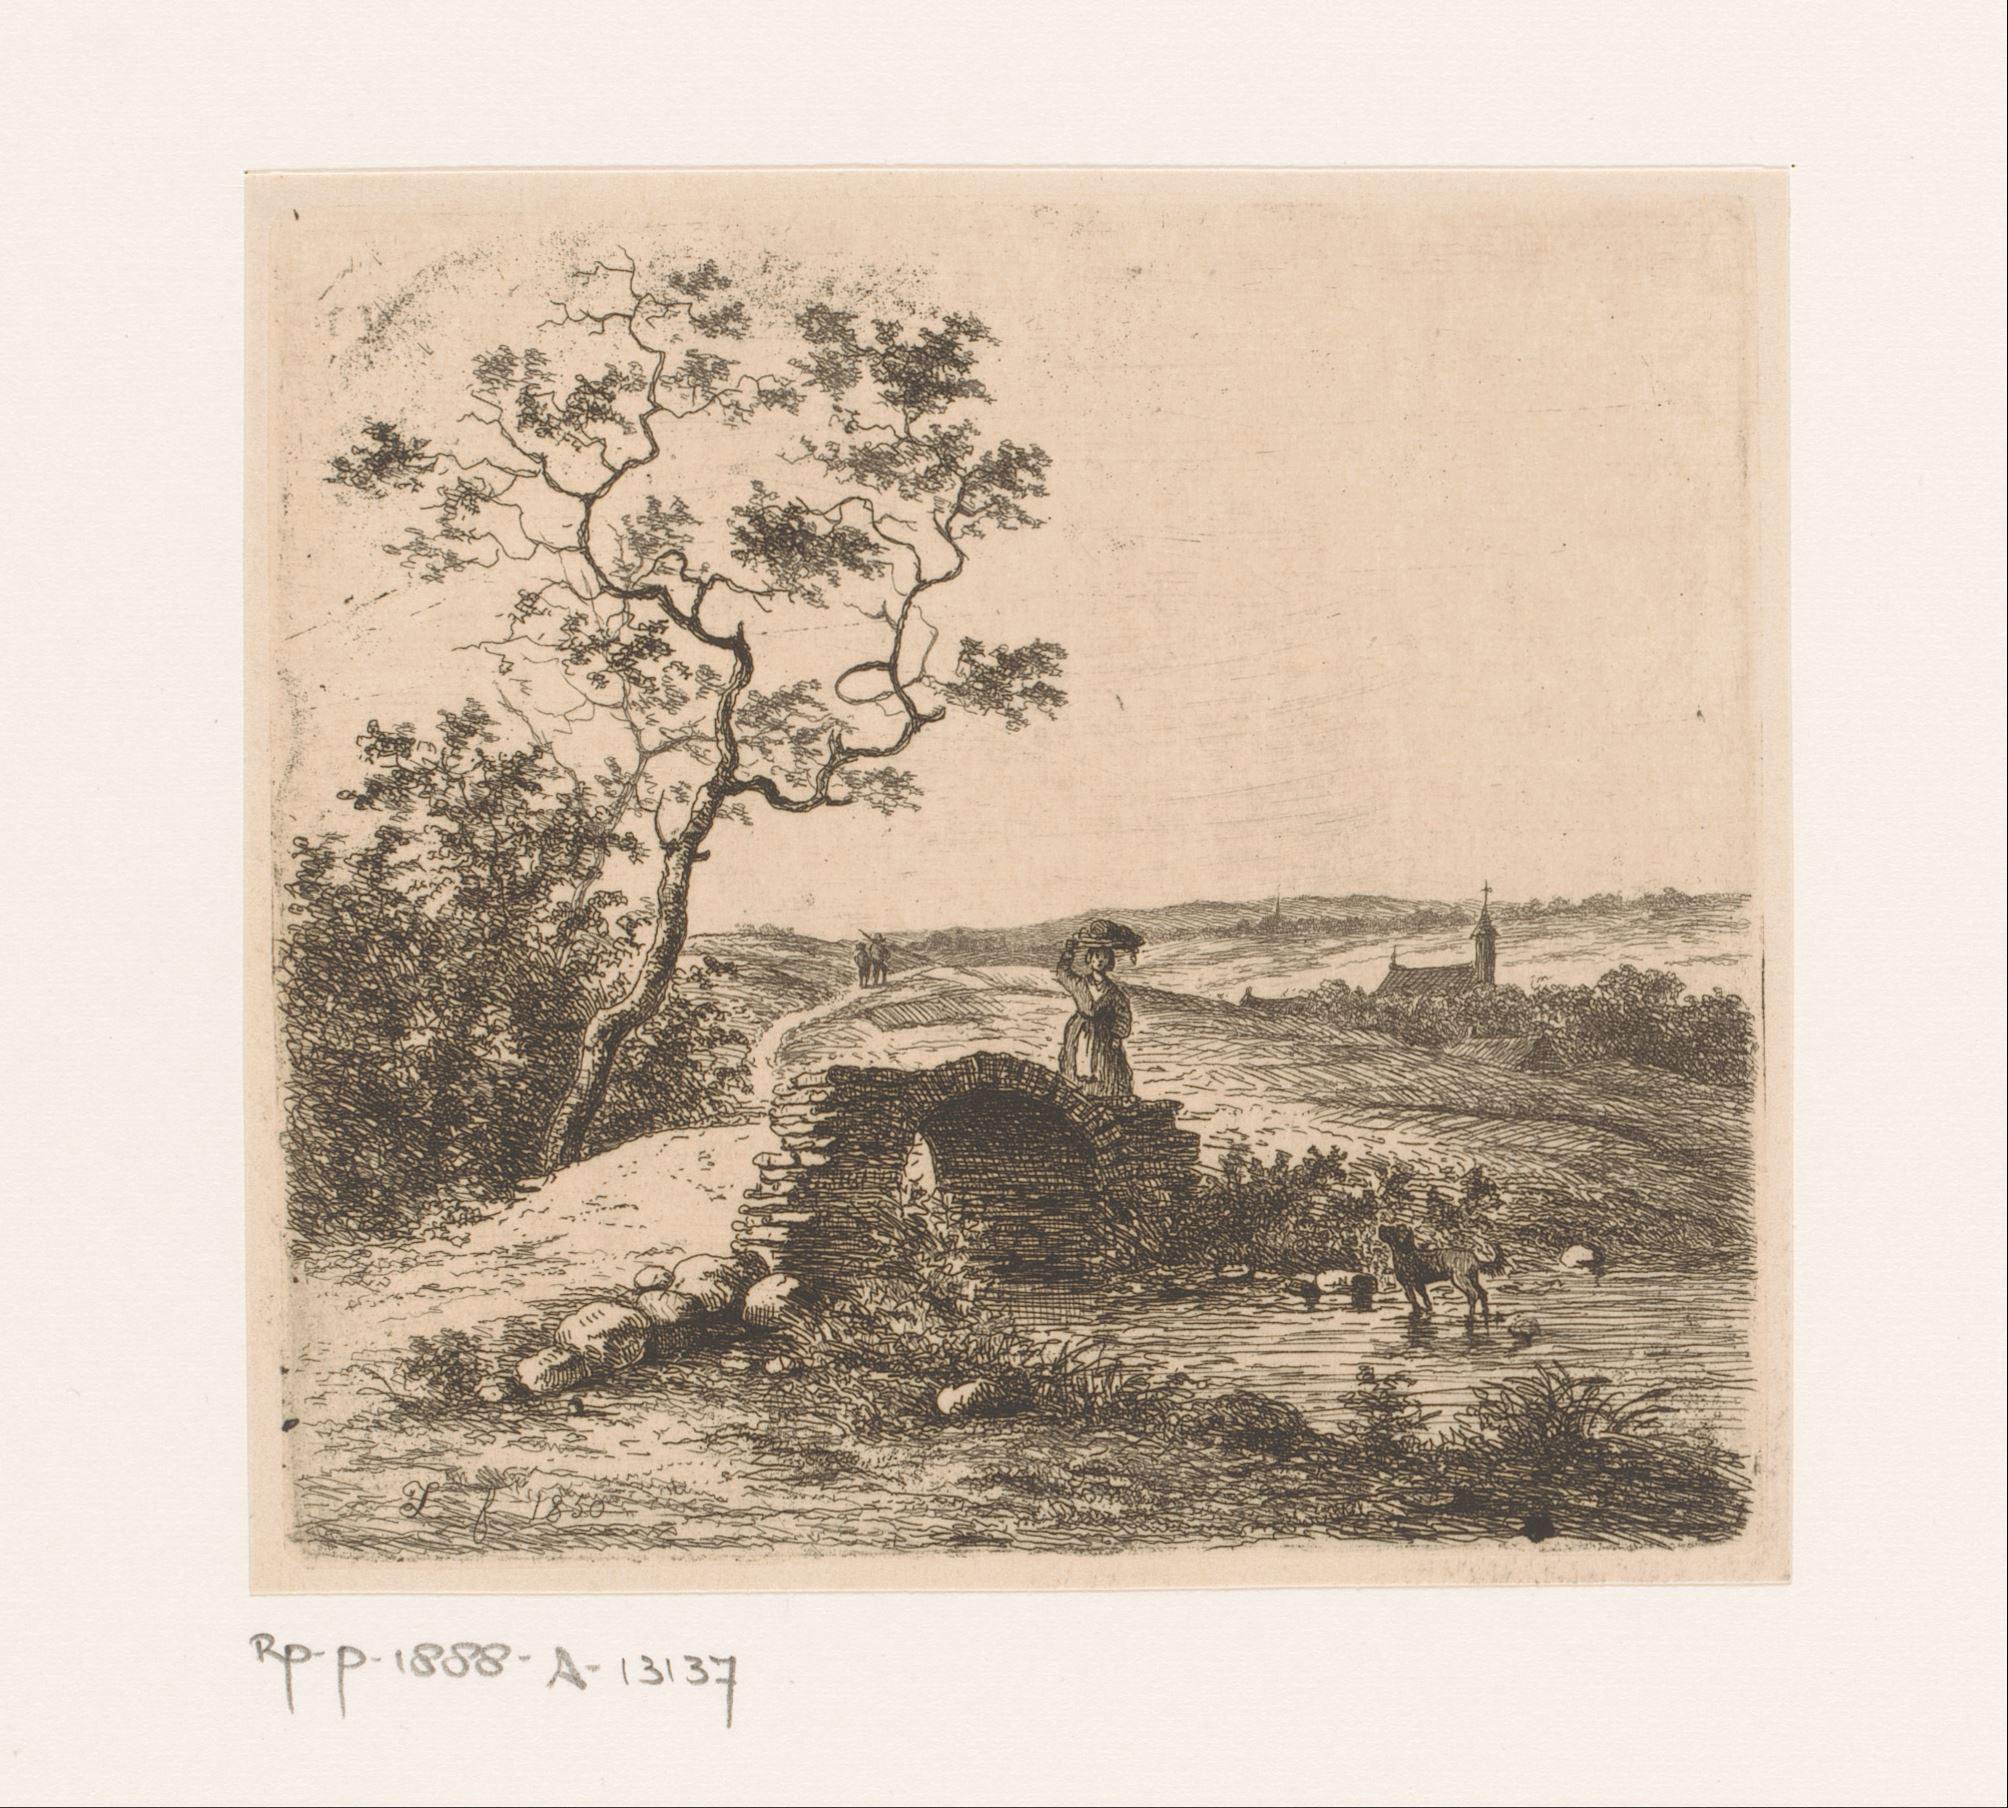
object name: print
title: Landschap met lage brug bij Pont-à-Marcq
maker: jean théodore joseph linnig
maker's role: draughtsman, print maker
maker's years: 1815-1891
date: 1850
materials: paper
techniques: etching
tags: landscape with bridge, viaduct or aqueduct, church (exterior)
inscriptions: collector's mark: Lugt 2228